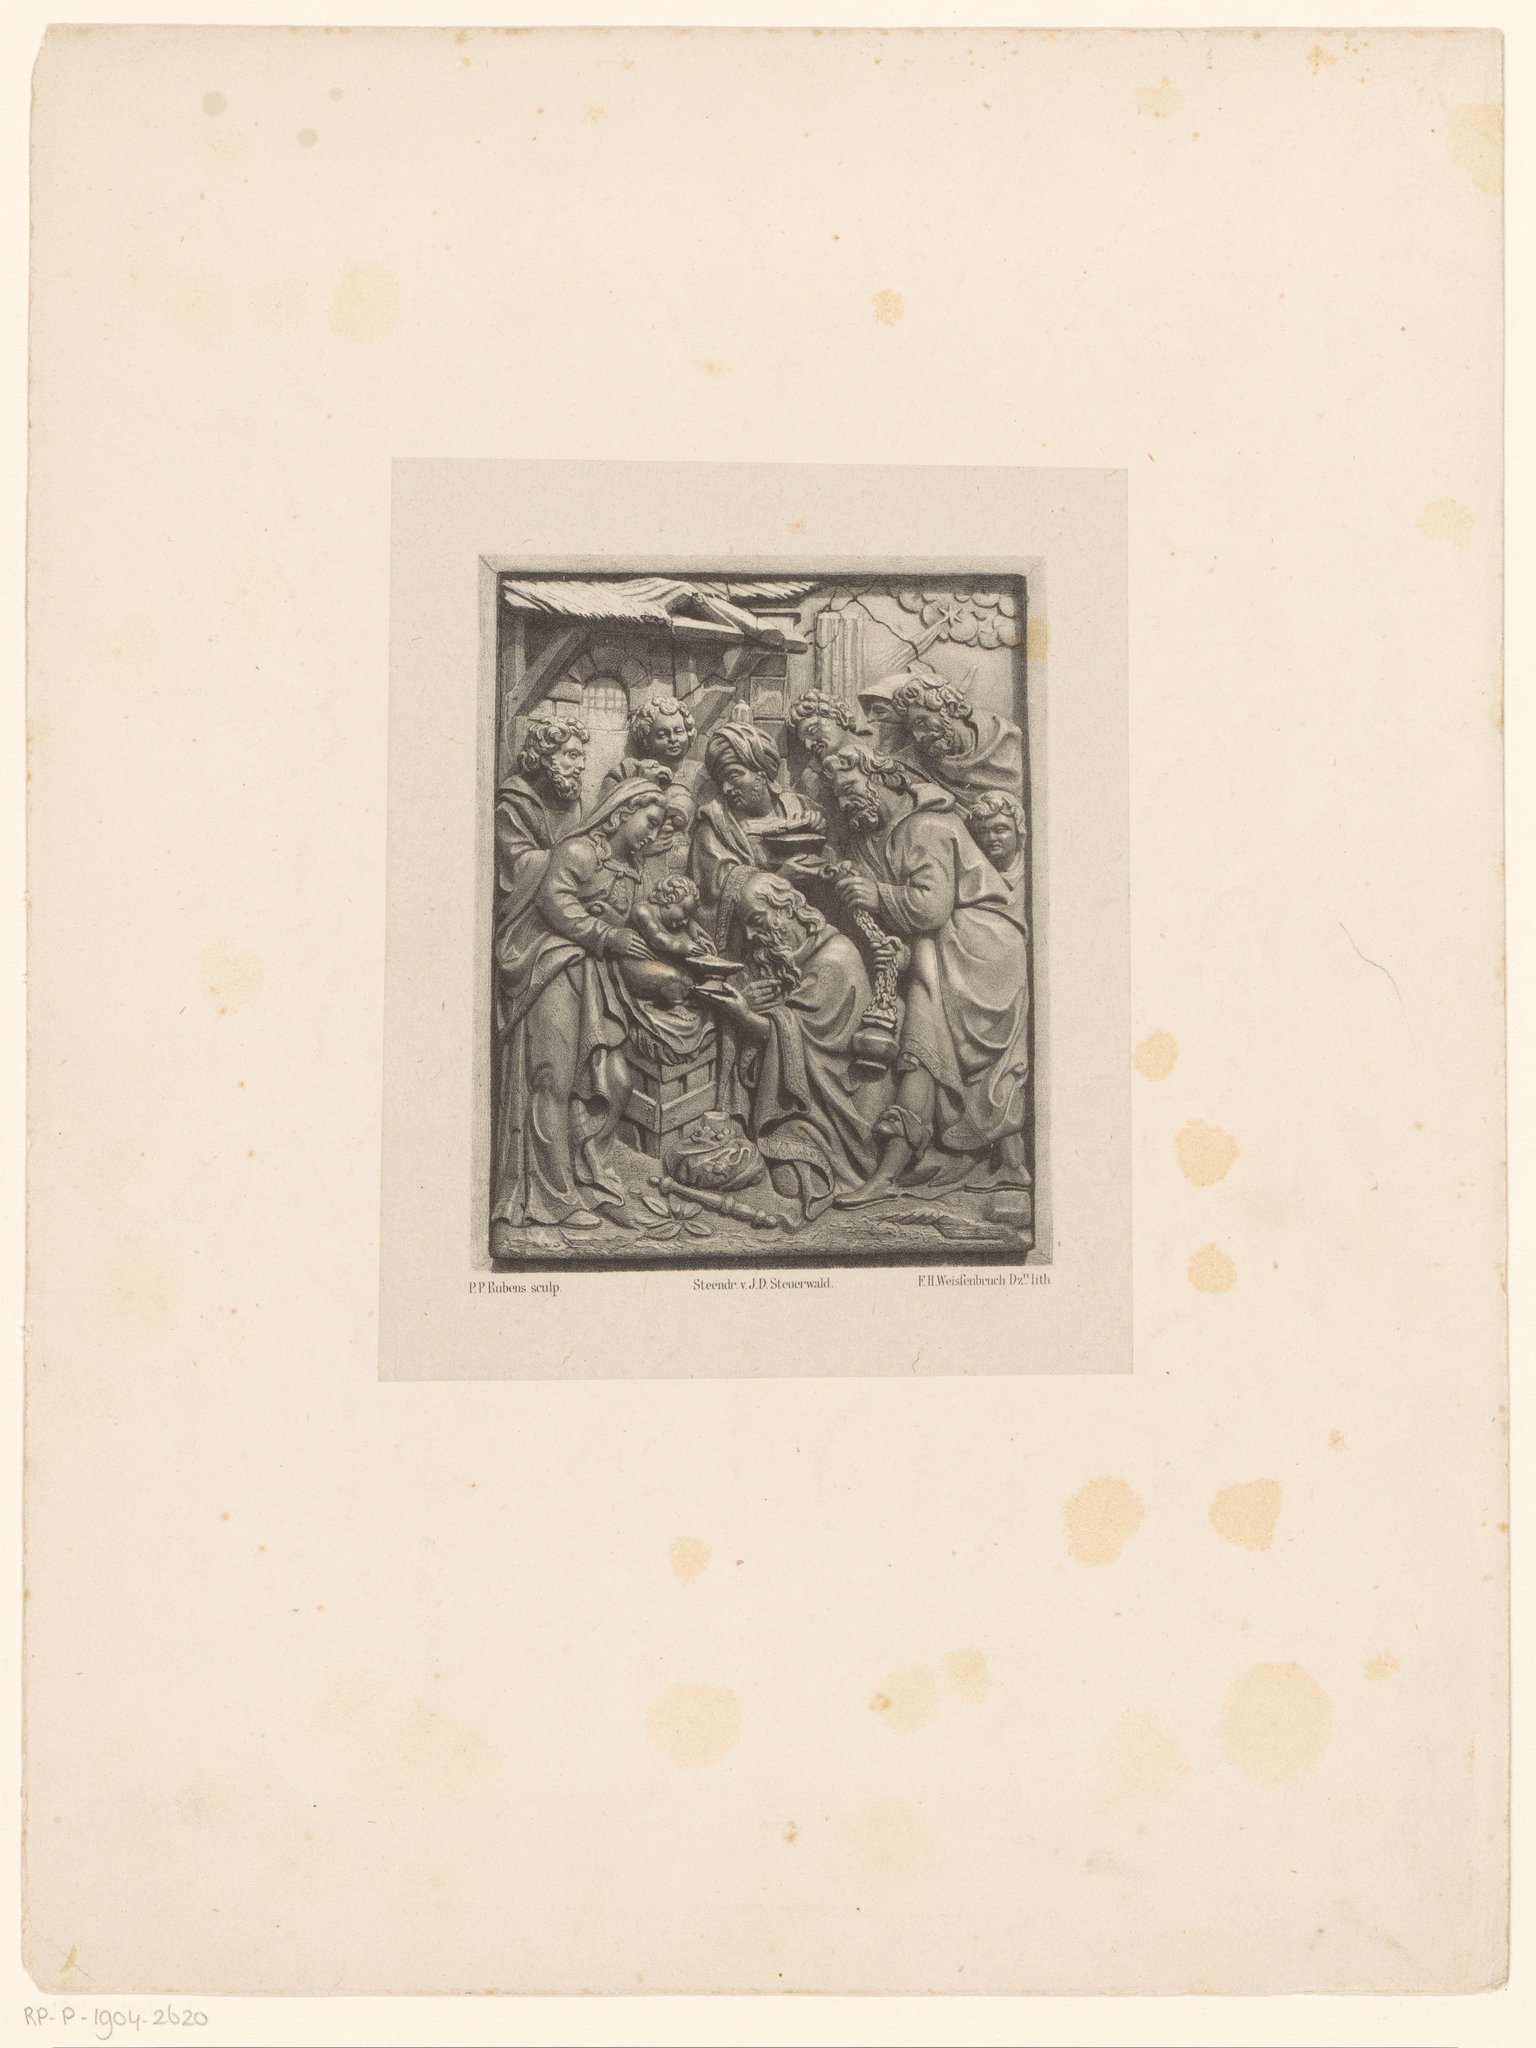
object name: print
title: Aanbidding door de koningen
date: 1838-1863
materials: paper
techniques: lithograph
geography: the hague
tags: adoration of the kings: the wise men present their gifts to the christ-child (gold, frankincense and myrrh)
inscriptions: collector's mark: Lugt 2228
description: De drie koningen en hun gevolg aanbidden het Christuskind dat op schoot zit bij Maria.